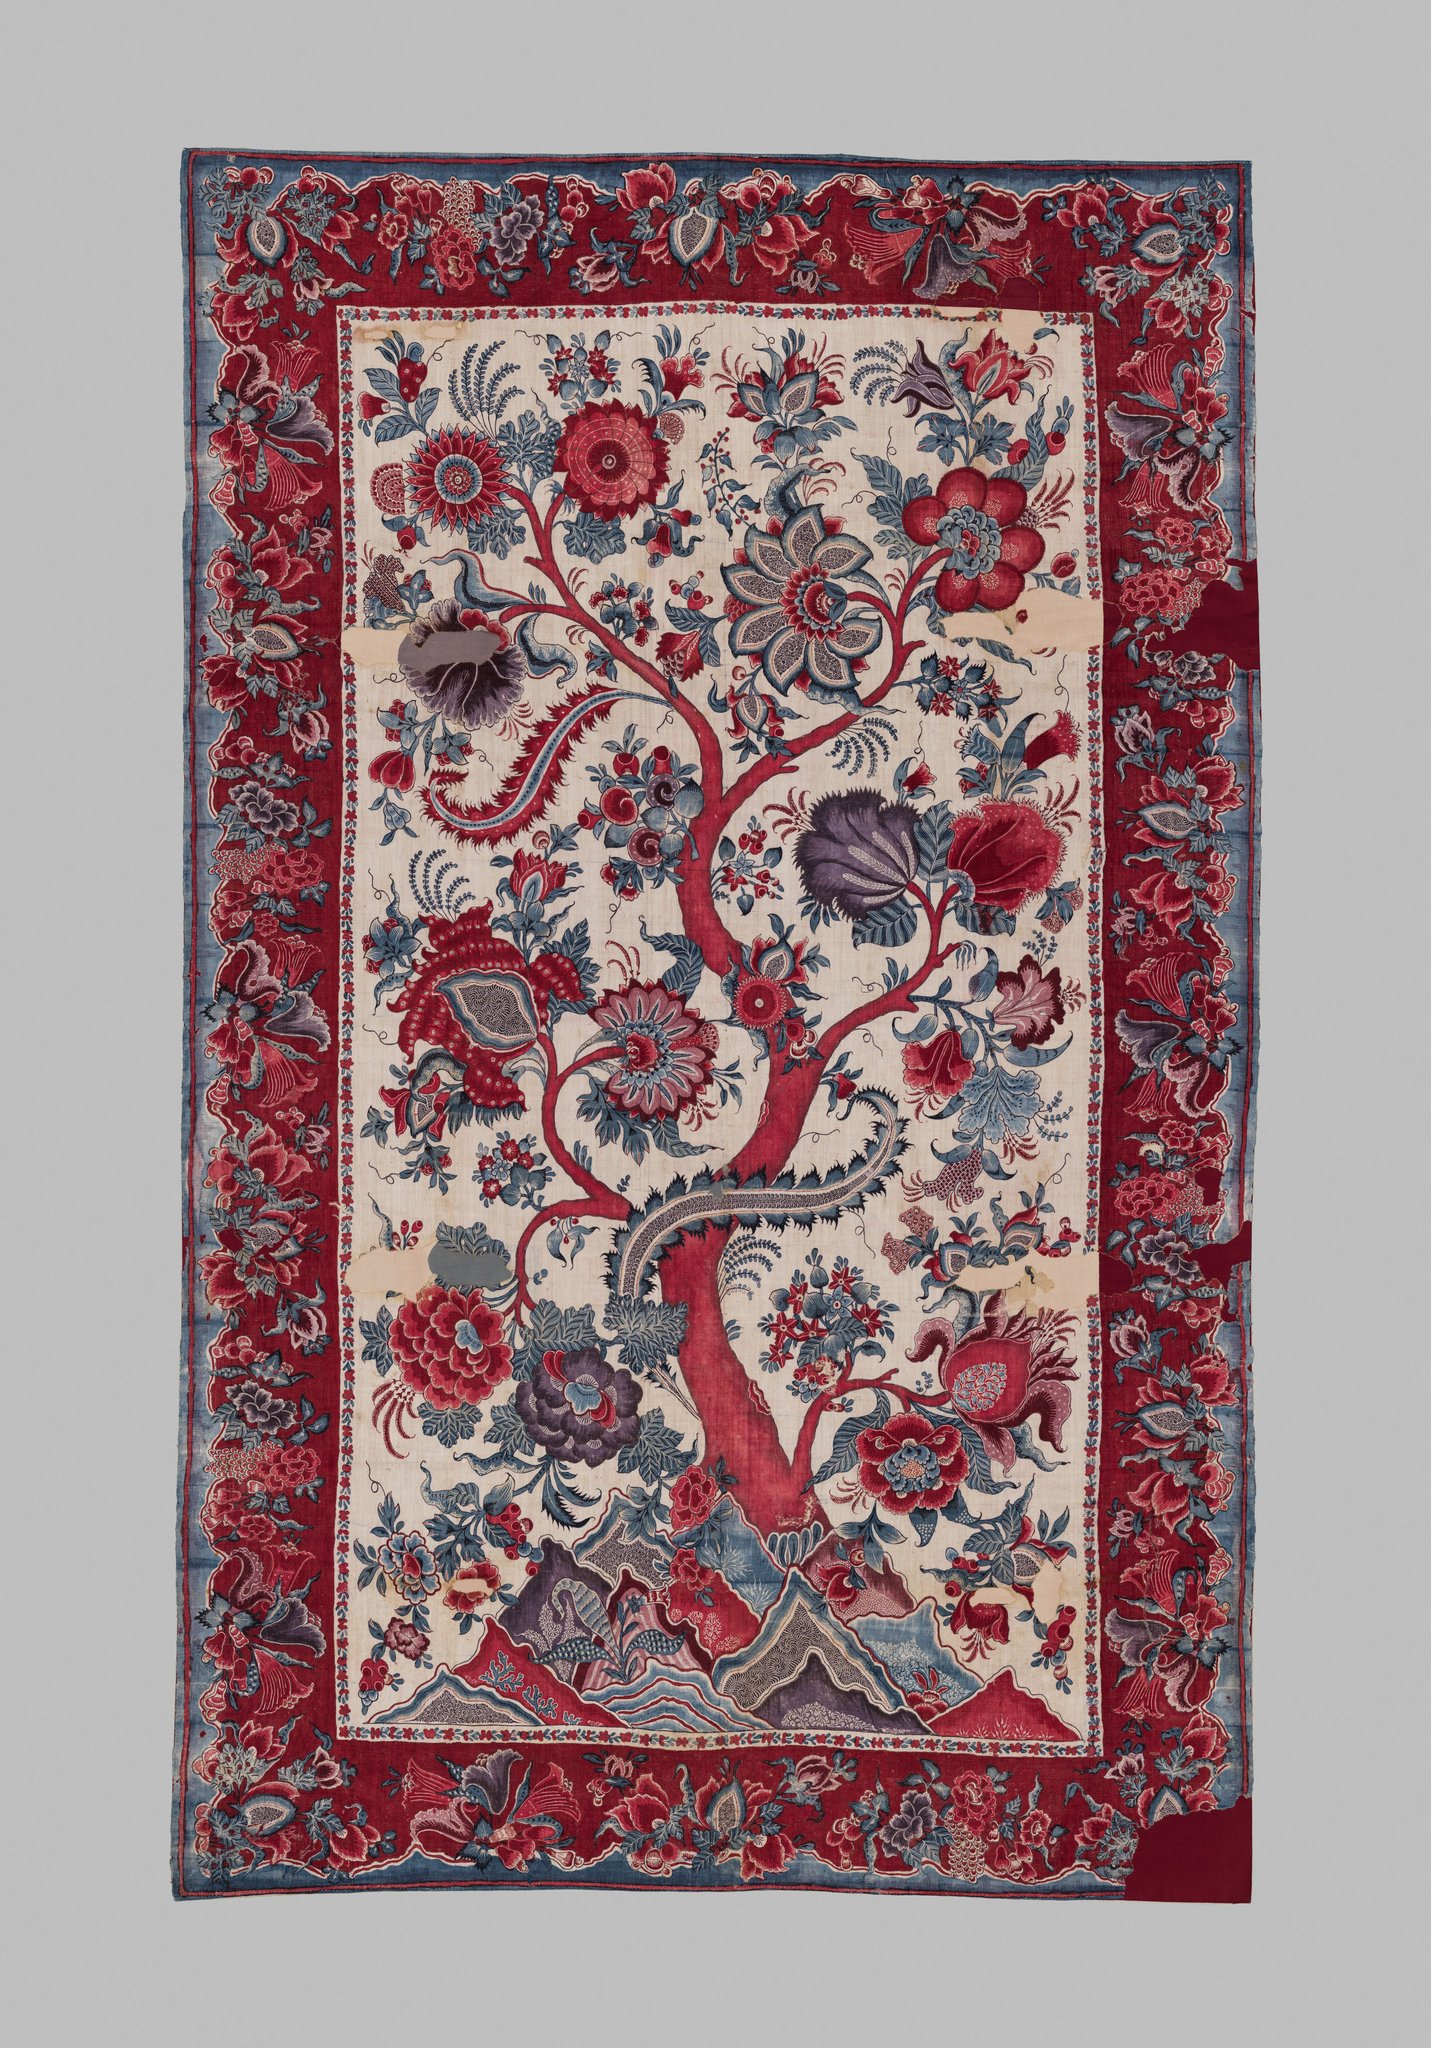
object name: palampore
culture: indian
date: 1701-1725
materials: cotton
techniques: dyeing, painting, resist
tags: flowers,trees